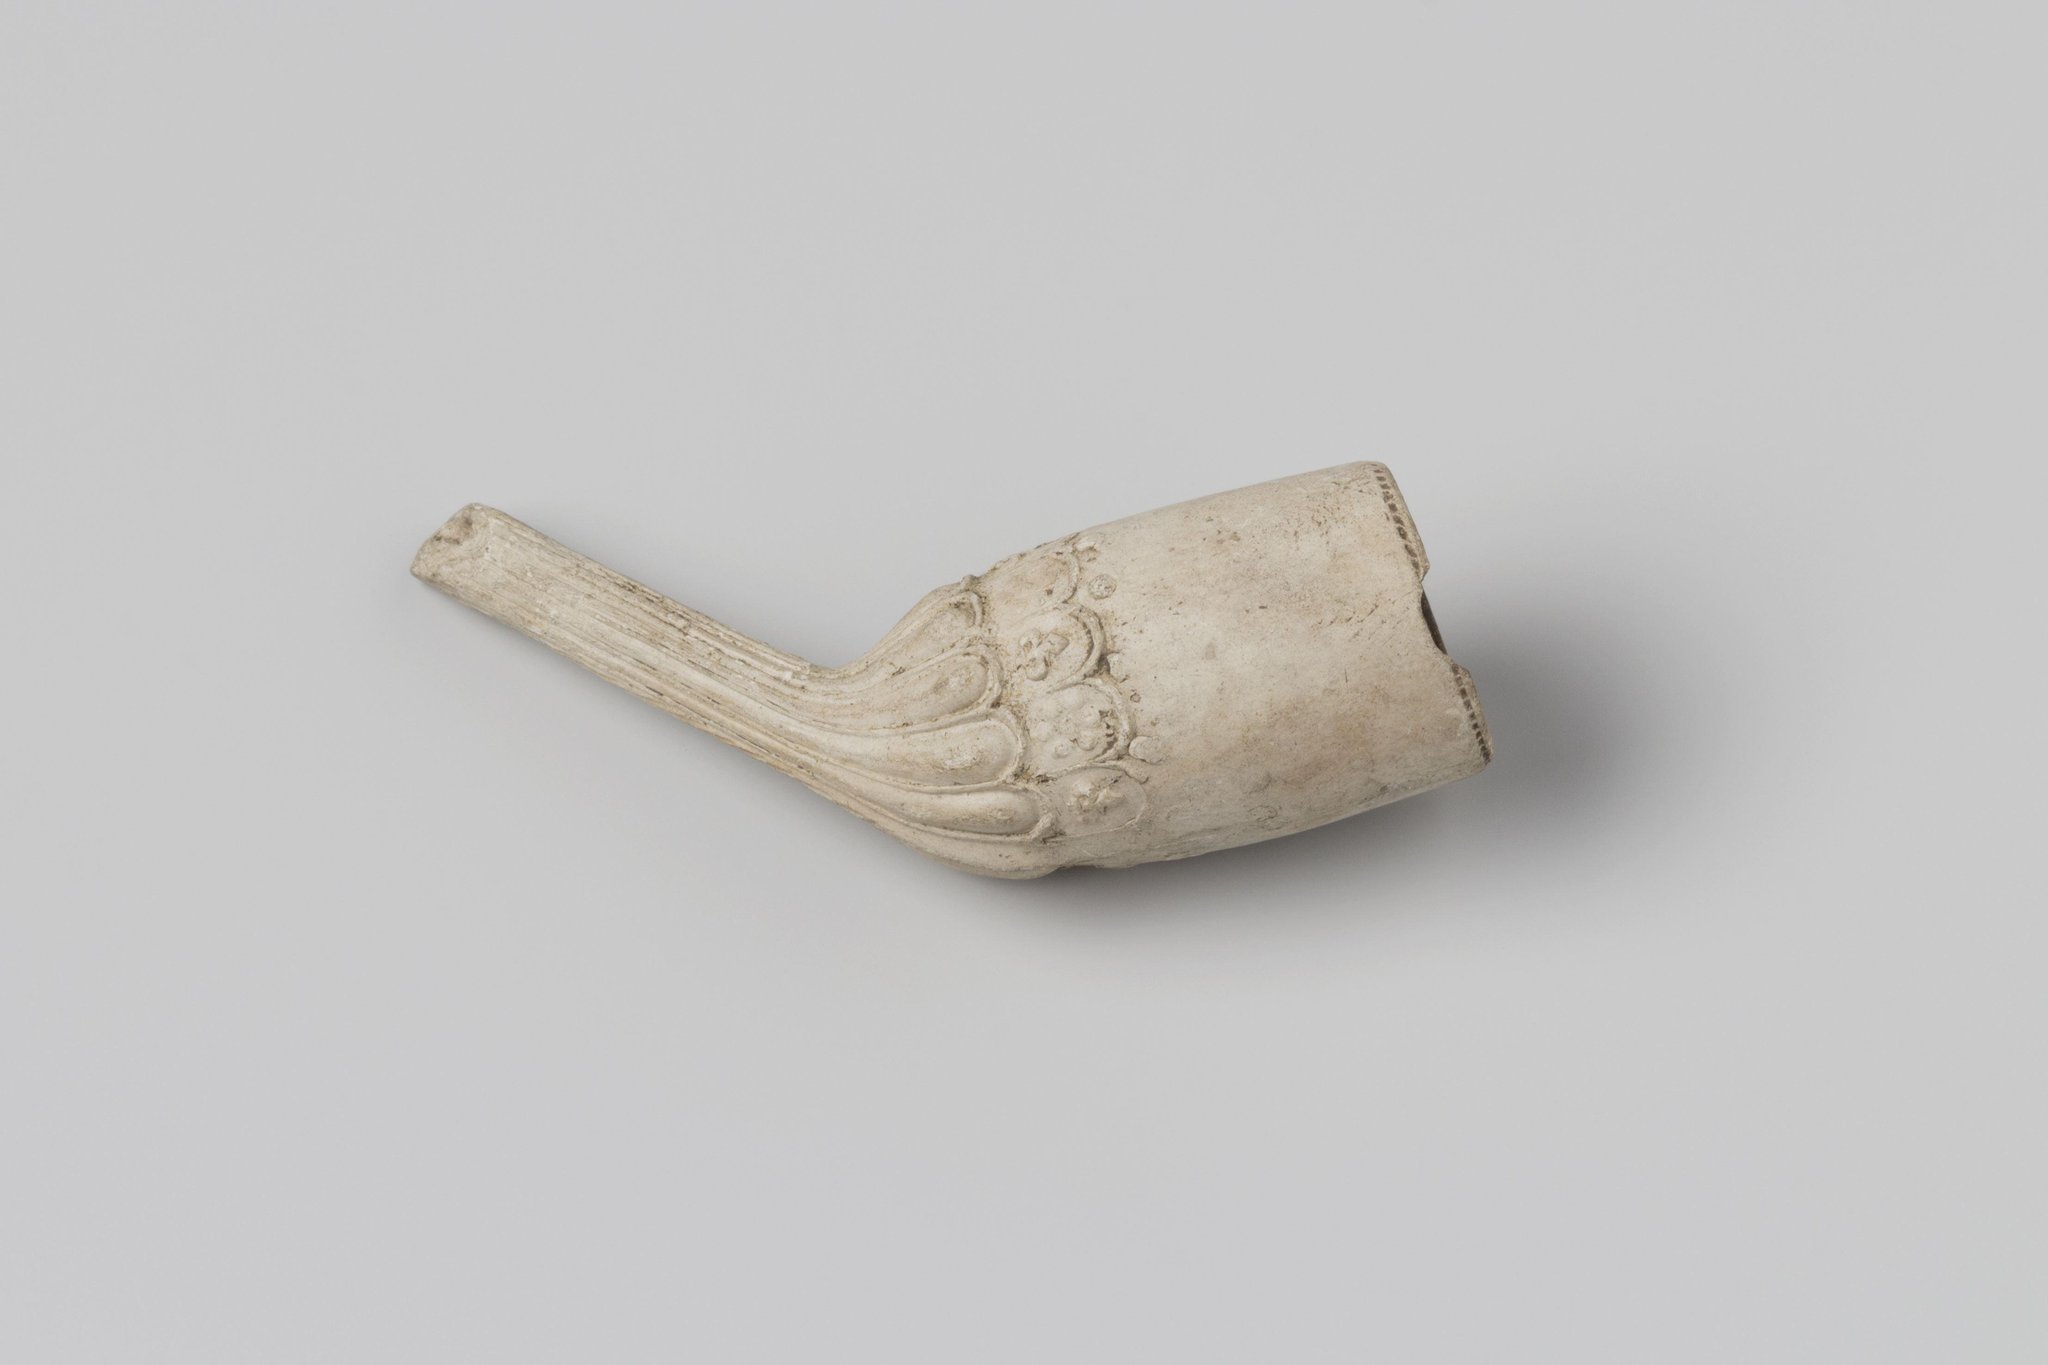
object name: fragment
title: Fragment tabakspijp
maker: jan nieuwveld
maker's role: pijpenfabrikant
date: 1740-1780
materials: clay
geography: gouda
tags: directeur, hoogleraar, caspar jacob christiaan reuvens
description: Fragment tabakspijp met knorren (floraal uitwaaiend motief) in omlijning, aan de bovenzijde eindigend in boogjes waarin afwisselend gestileerde roosjes en lelies en boven de boogjes een rij bloempjes. Van de opgravingen op de Hofstede Arentsburg 1827-1831 onder toezicht van Professor Reuvens.